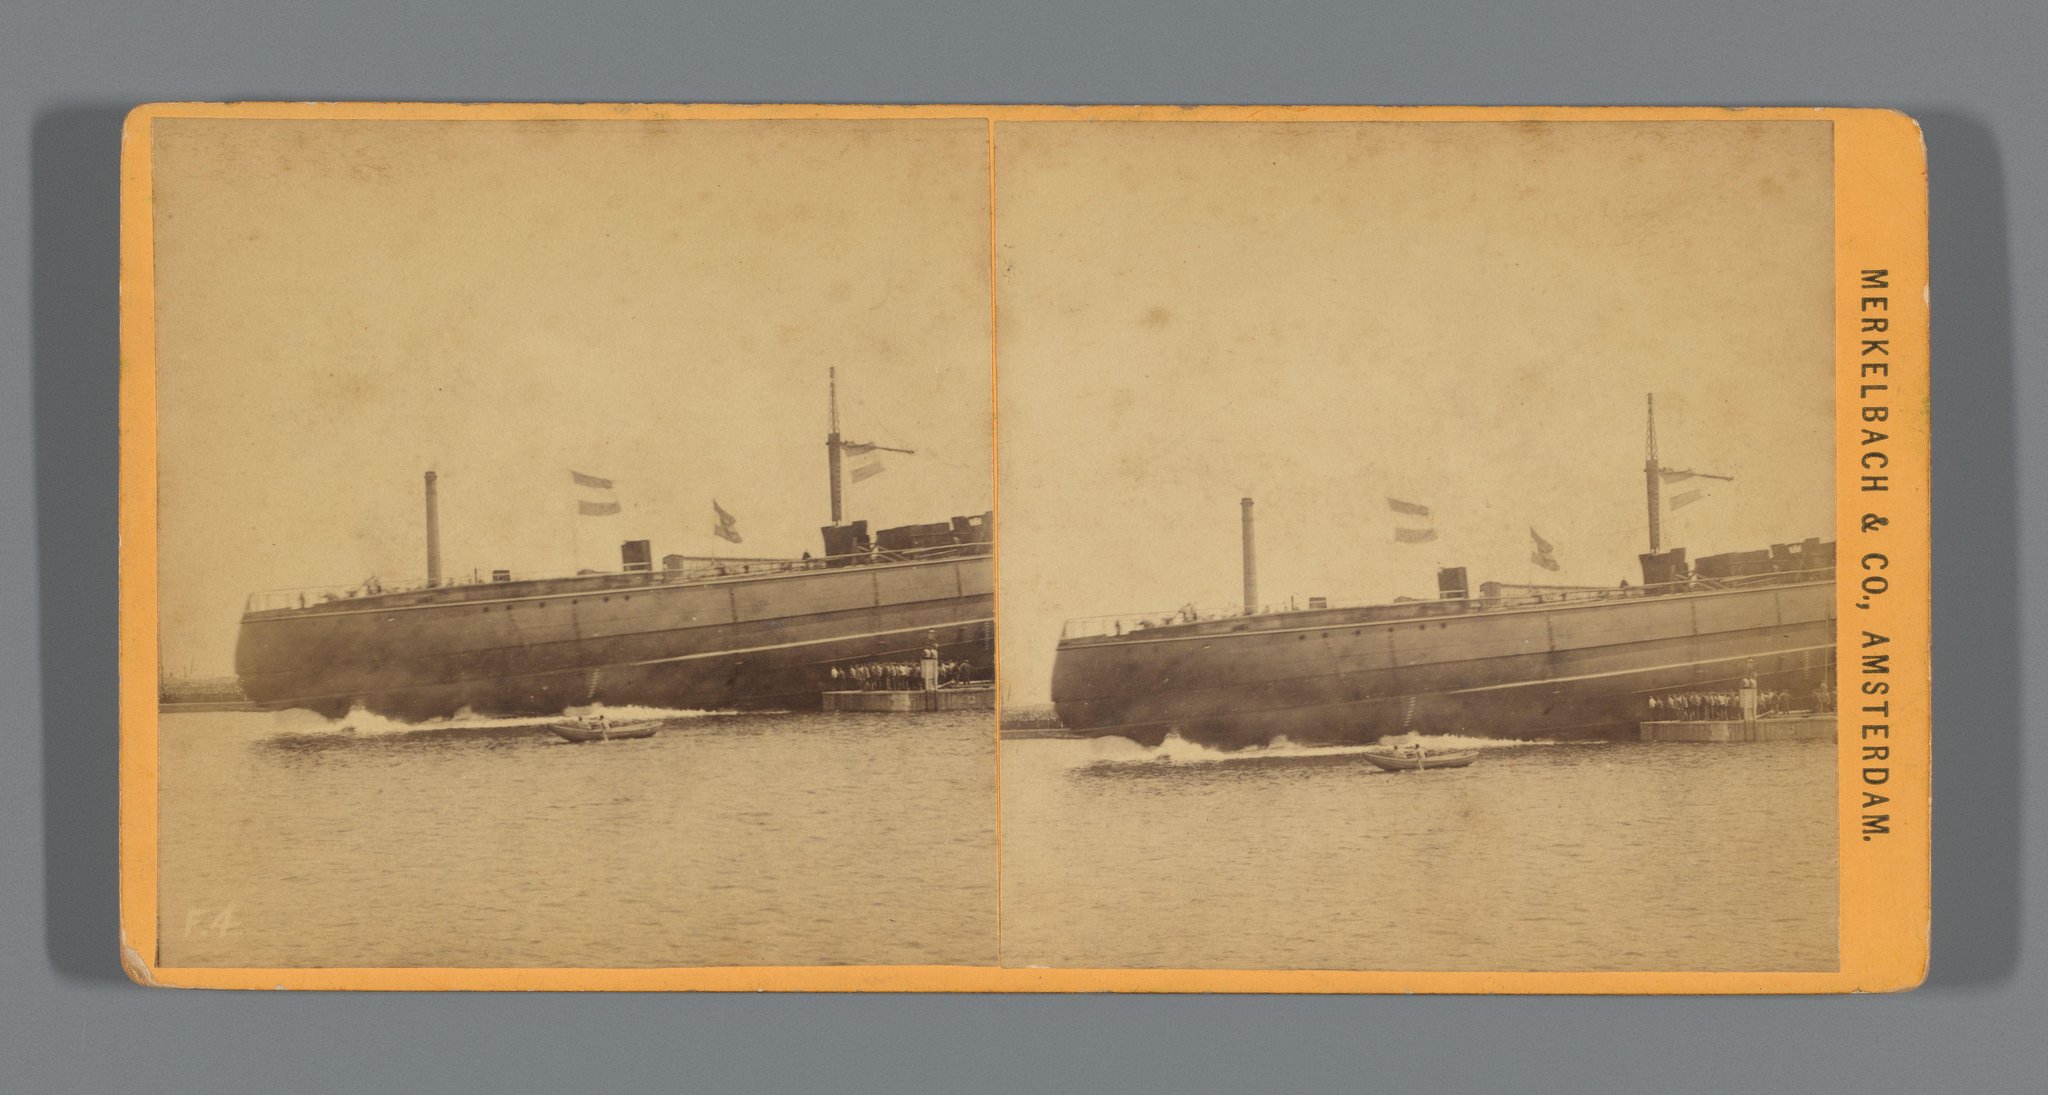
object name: stereograph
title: Aardrijkskundige Beeldengalerij, verzameld door M.J. Broekhuijsen, Hoofd eener school te Amsterdam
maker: martien johan broekhuijsen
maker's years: 1871-1956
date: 1905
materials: photographic support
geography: amsterdam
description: Onderdeel van een groep van 52 stereofoto's gebruikt in het lager onderwijs als aanvulling op schoolplaten. De gehele reeks bestond uit 274 nummers in 10 categorieën (A t/m K).